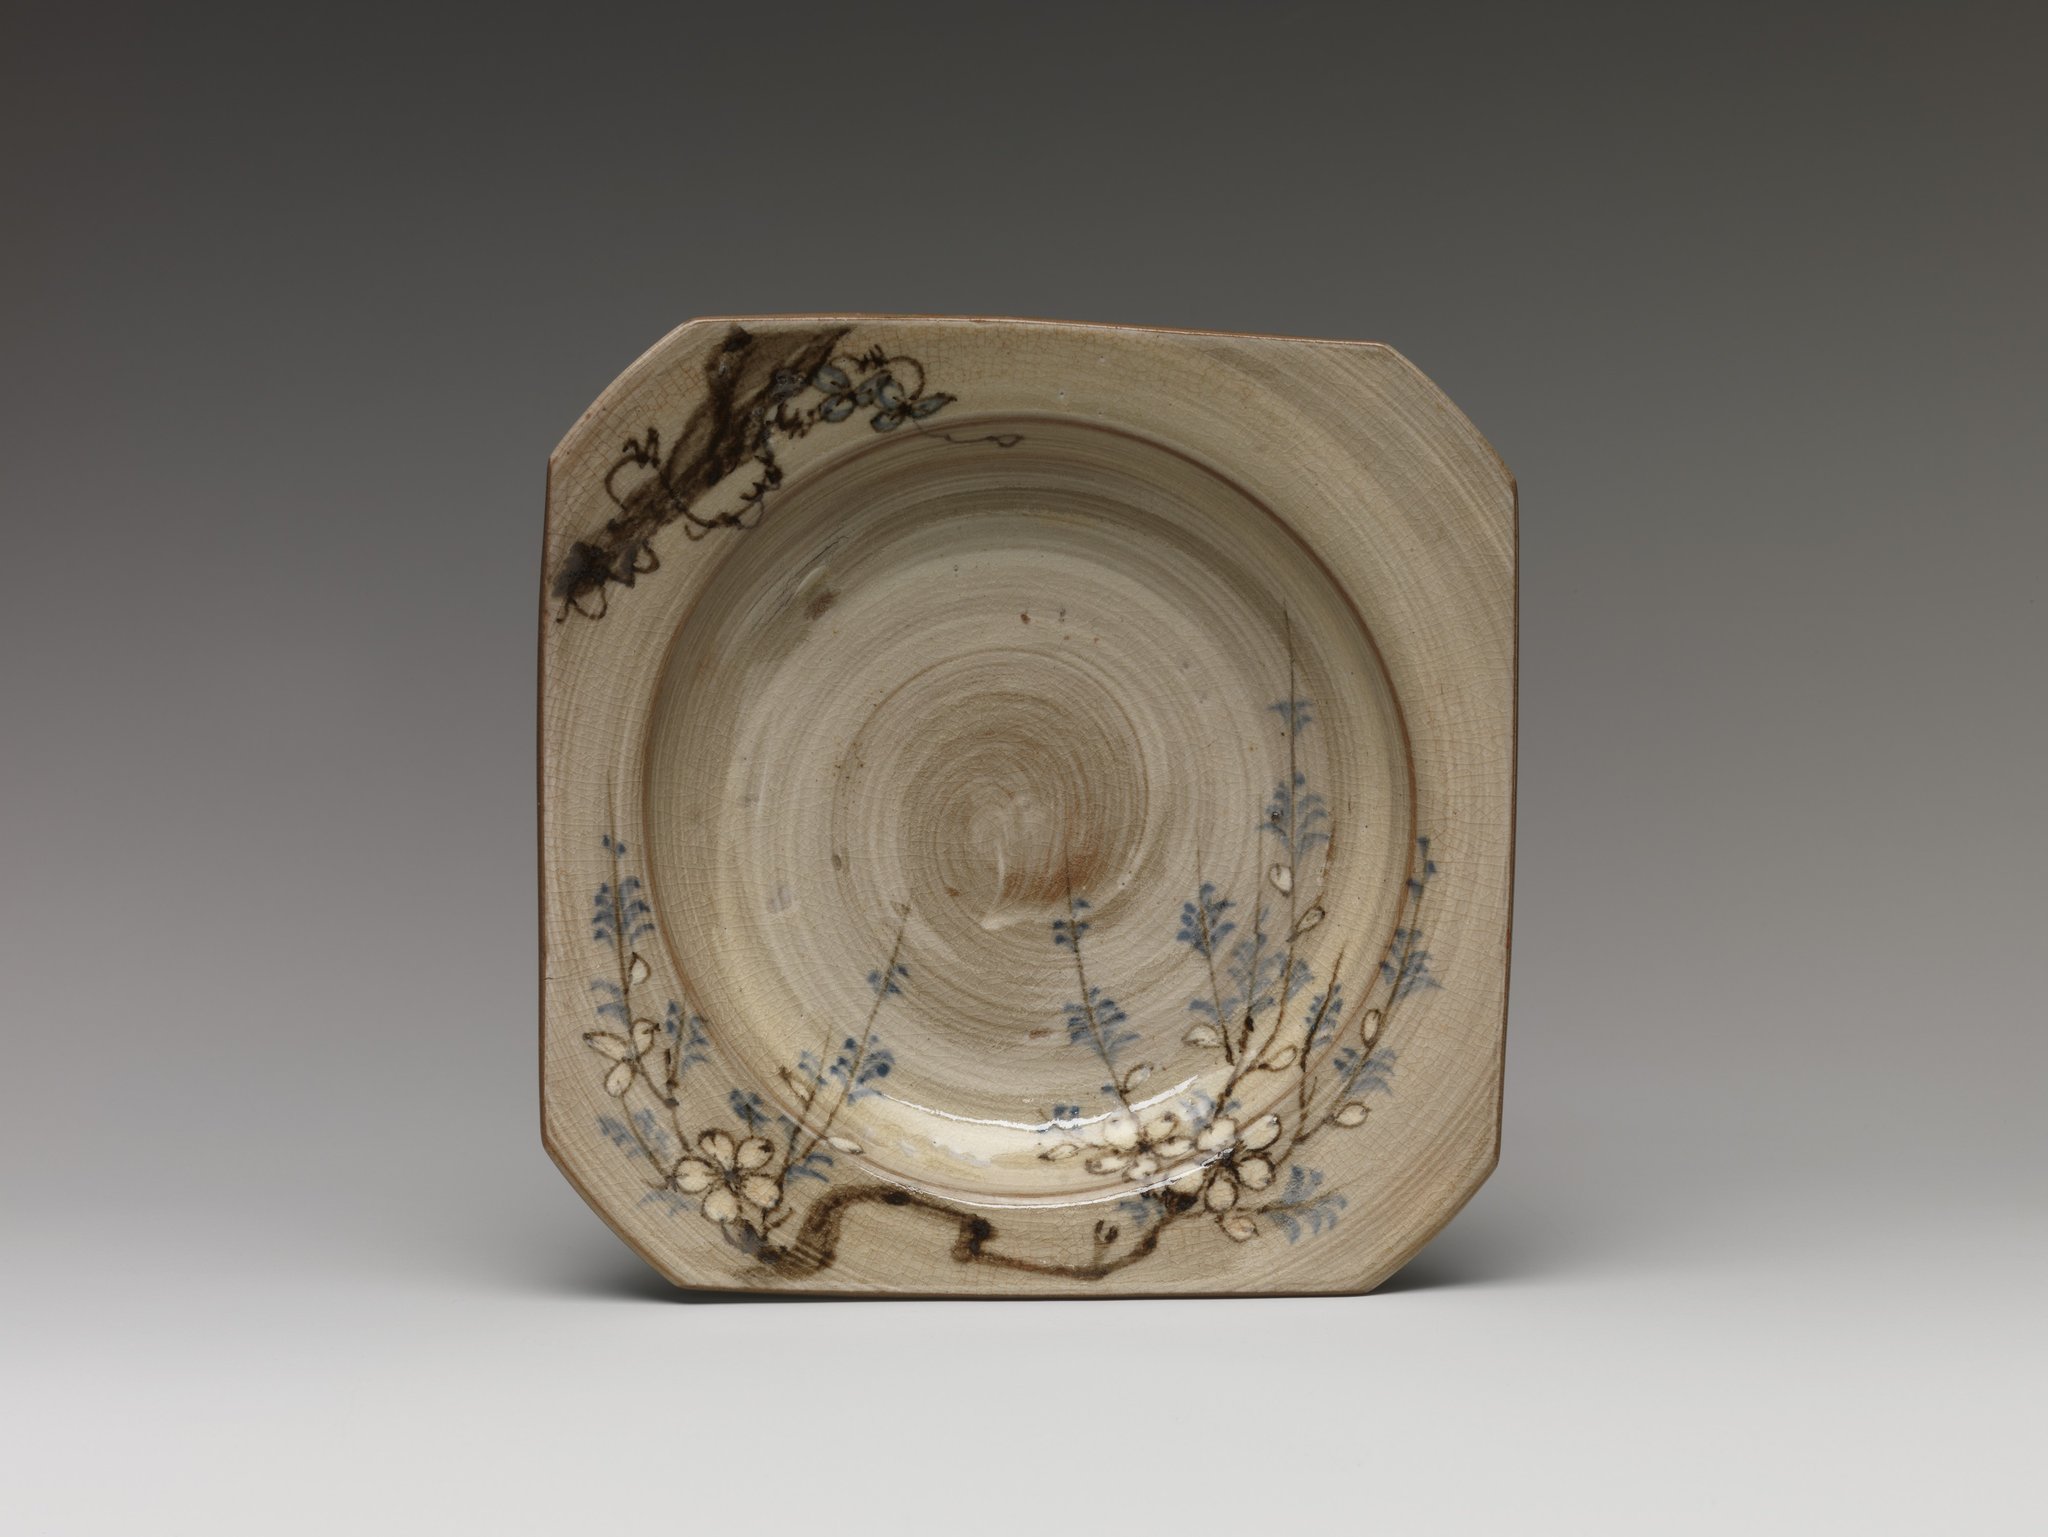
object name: dish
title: Square Dish with Decoration of Cherry Blossoms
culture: japanese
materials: cobalt, iron, stoneware